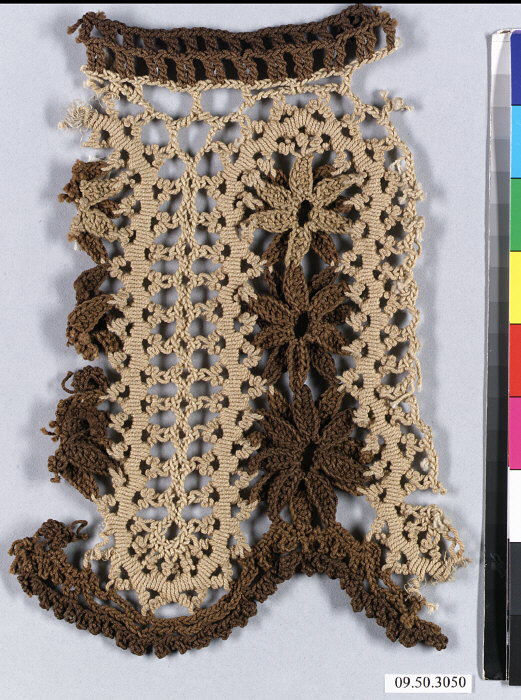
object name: sample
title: Crochet Work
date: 1801-1900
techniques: crochet